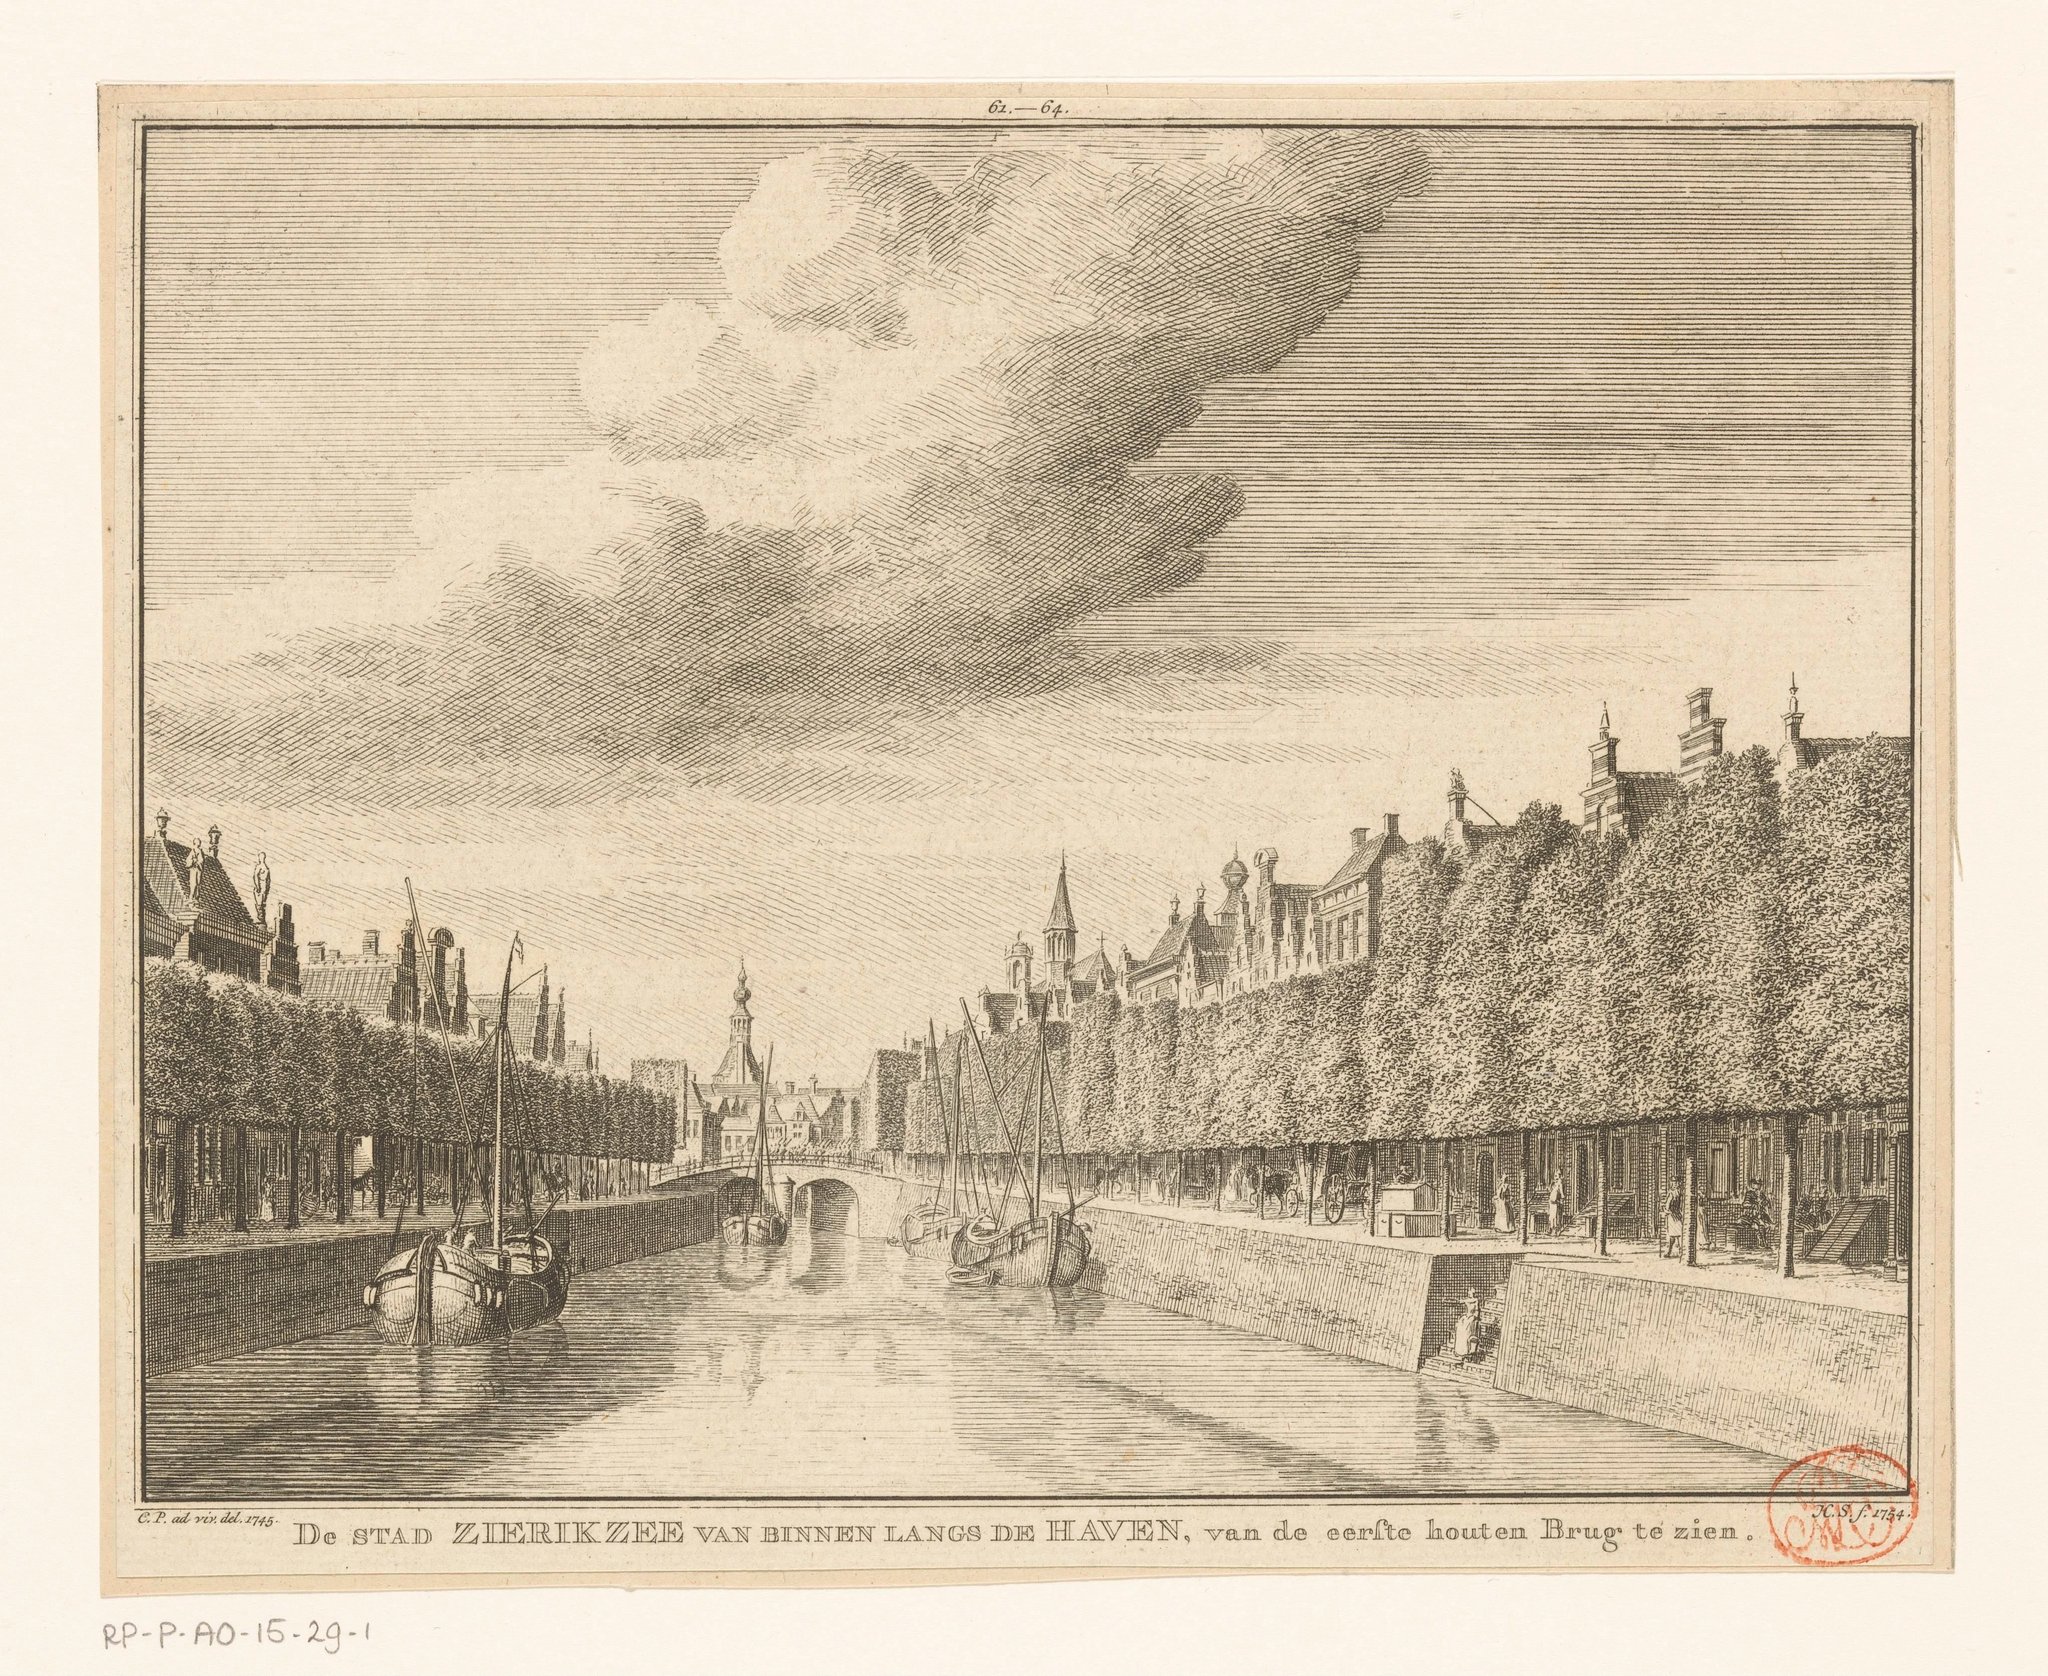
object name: book illustration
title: Gezicht binnen Zierikzee, 1745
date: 1754-1792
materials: paper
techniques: engraving, etching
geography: haarlem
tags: harbour, bridge in city across river, canal, etc. - ii - ideal city, church (exterior), canals, waters (in city), prospect of city, town panorama, silhouette of city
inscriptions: collector's mark: Lugt 195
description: Prent ook gebruikt in: Het verheerlykt Nederland of kabinet van hedendaagsche gezigten van steden, dorpen (…). 9 delen. Amsterdam: Isaak Tirion en weduwe Isaak Tirion, 1745-1774, dl. 5 (1754), ill. 61-64. Of in: Nederlandsche tafereelen; of eene keurige verzameling van negen honderd fraaije gezigten van steden, dorpen, sloten, oudheden [….]. 9 delen. Amsterdam: Jan de Groot, 1792, dl. 5, ill. 61-64.